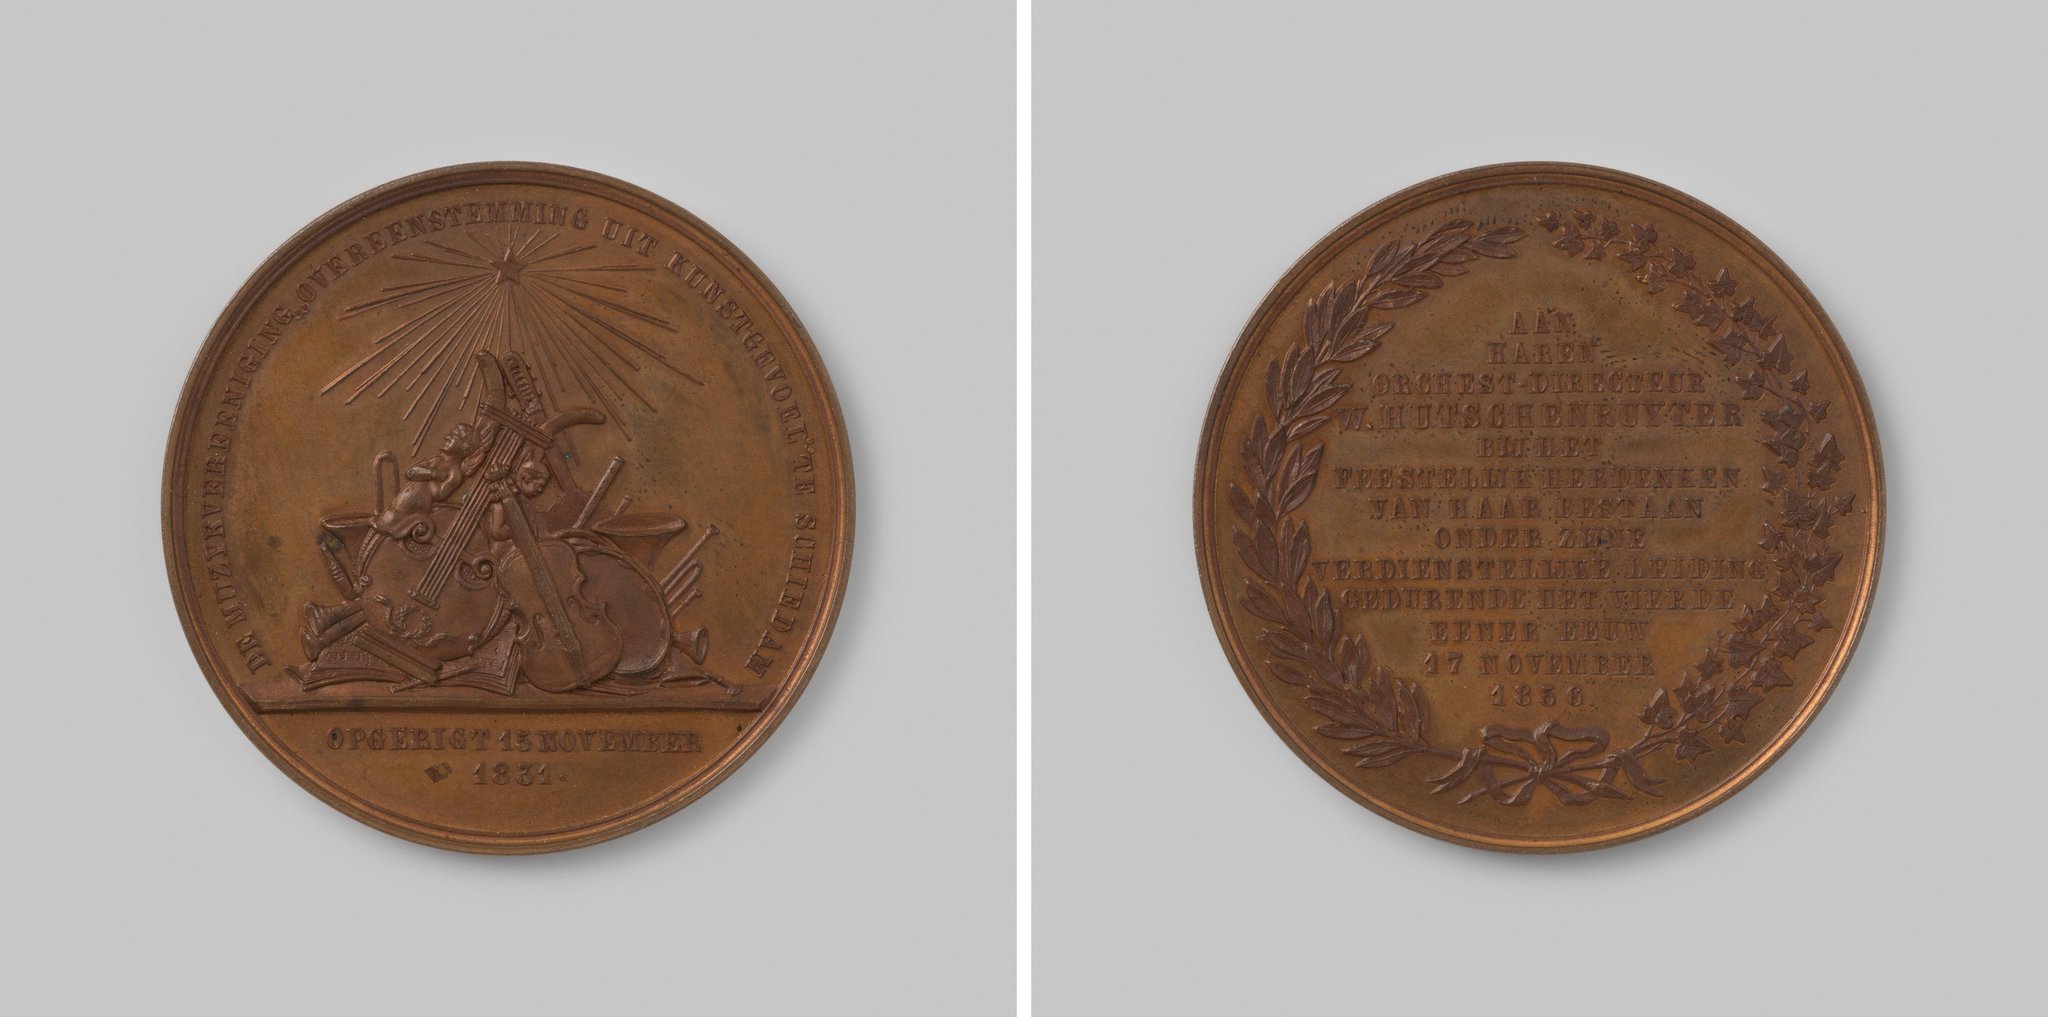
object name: honorary medal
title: Vijfentwintigjarig bestaan van het muziekgezelschap "Overeenstemming uit Kunstgevoel" te Schiedam, ter ere van de directeur van het orkest, W. Hutschenruyter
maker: Anonymous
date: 1856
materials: bronze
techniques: striking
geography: netherlands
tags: wouter hutschenruyter, schiedam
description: Bronzen penning. Voorzijde: groep muziekinstrumenten, bestaande uit lier, gitaar, viool, waldhoorn, pauken, trompetten, muziekboek, beelden e.d. onder stralende ster binnen omschrift; afsnede: opschrift. Keerzijde: opschrift binnen tot krans samengebonden lauwer- en klimoptak.